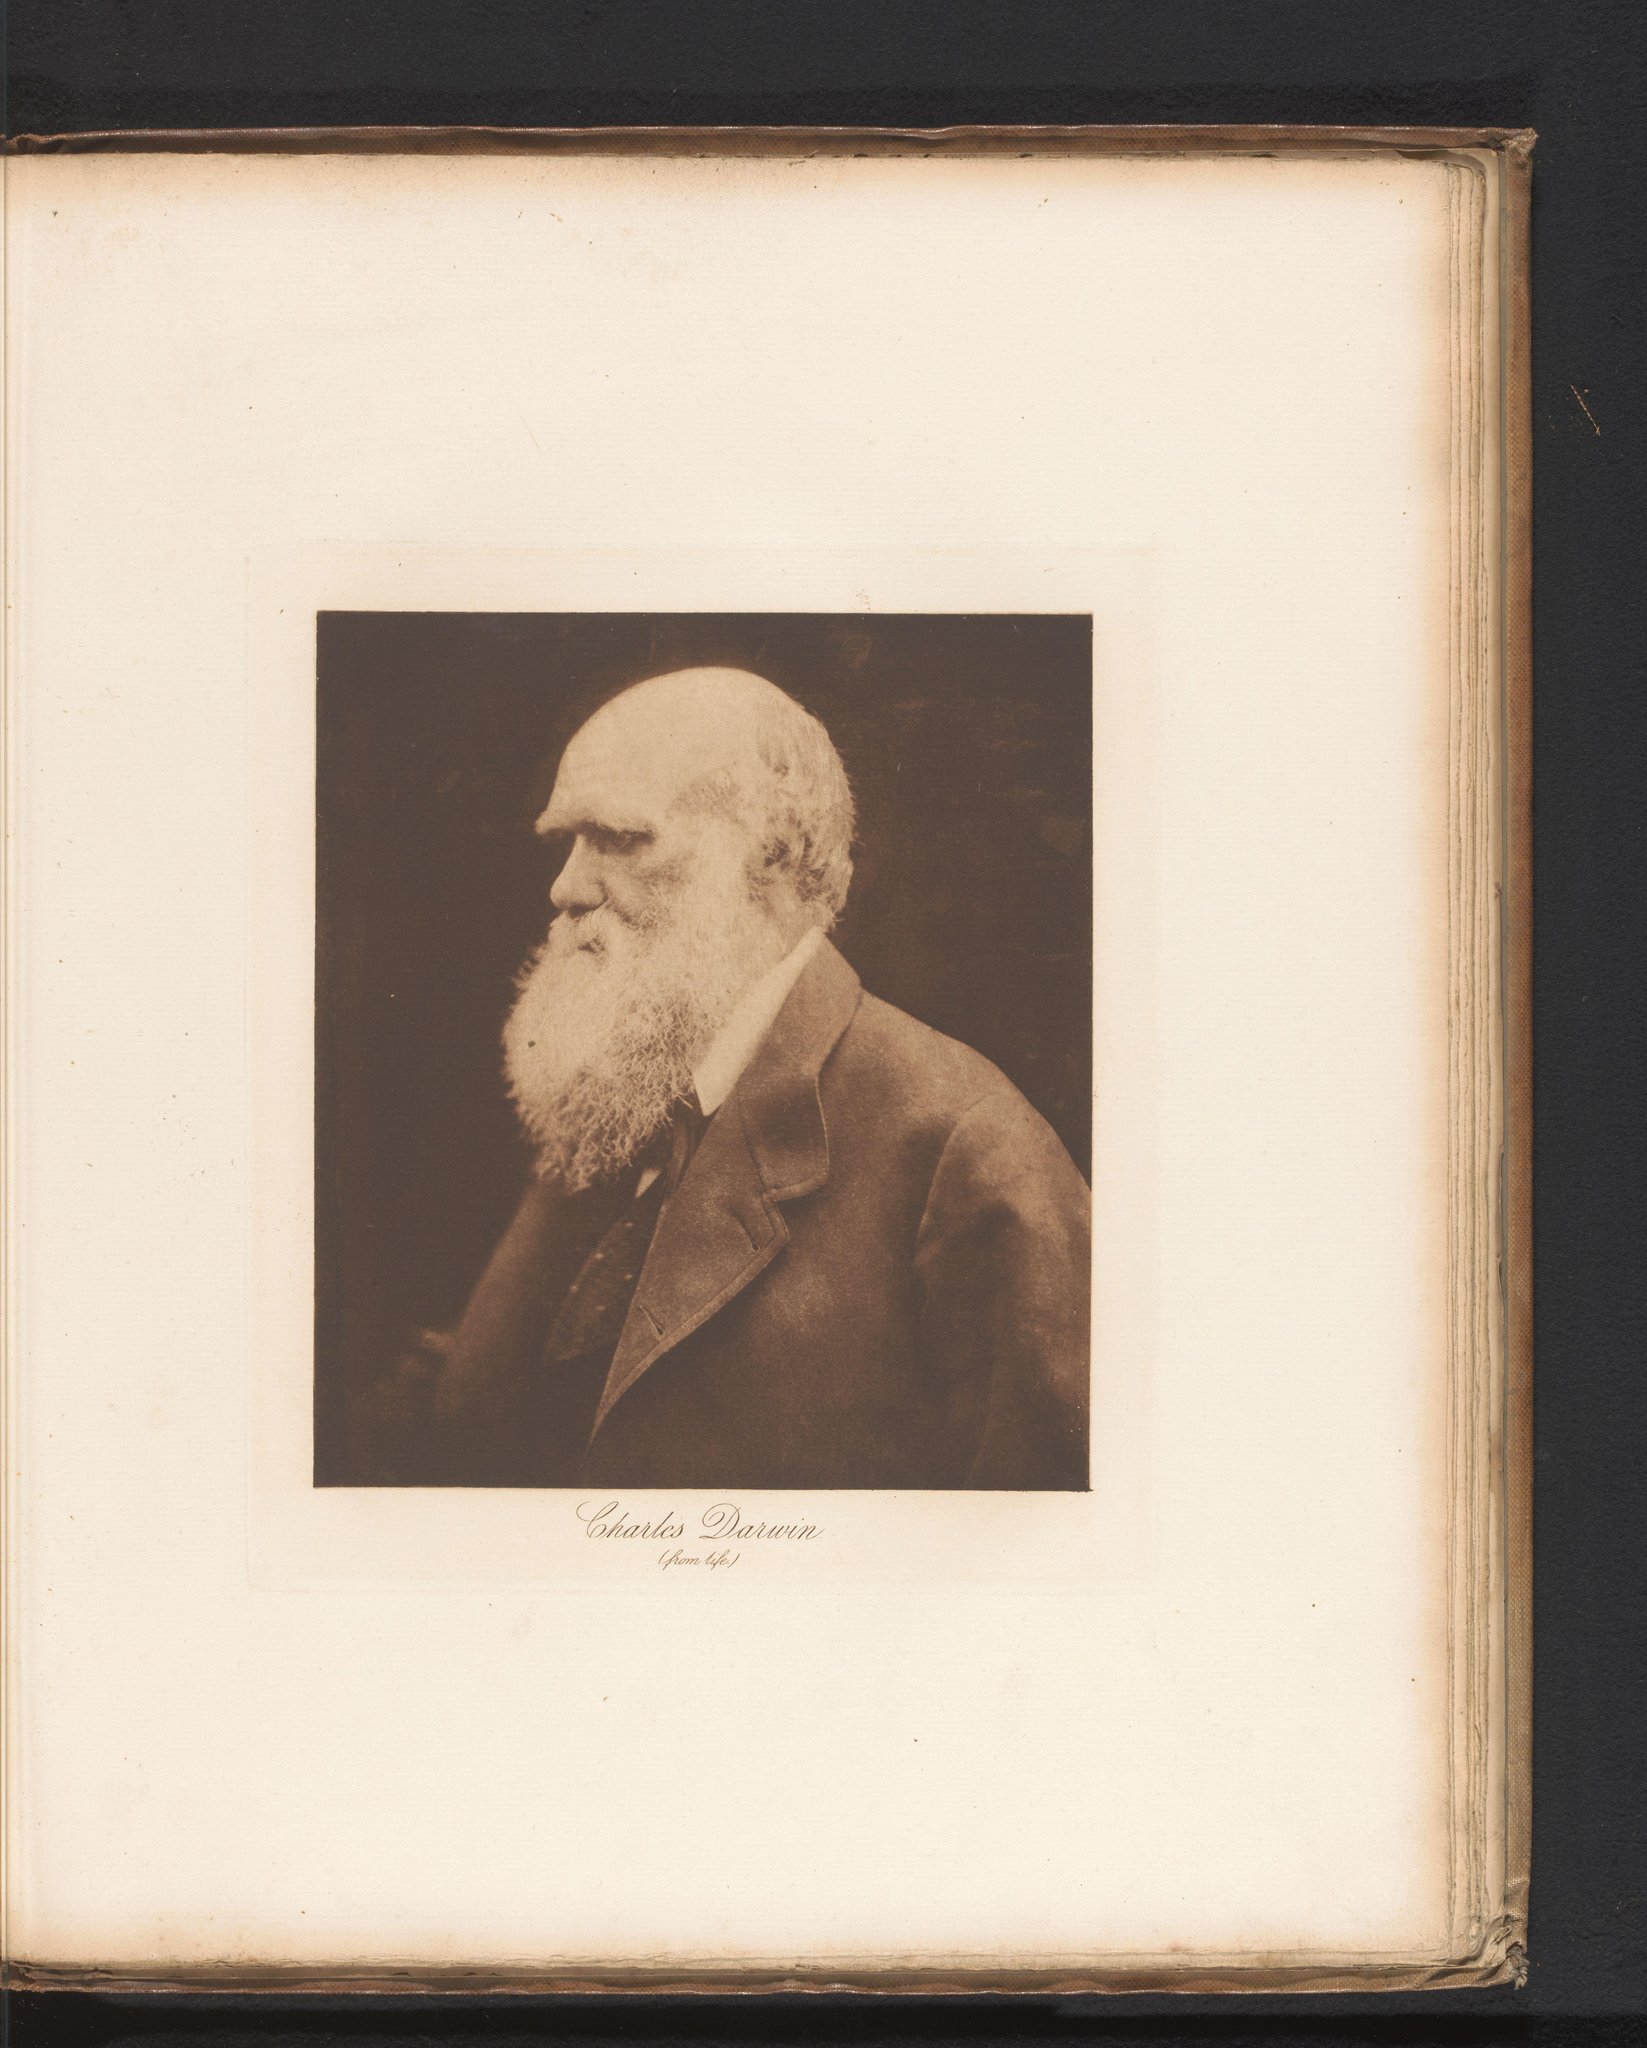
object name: page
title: Charles Darwin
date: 1868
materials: paper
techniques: photoaquatint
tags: charles darwin, historical persons, biology (+ portrait of scholar, scientist)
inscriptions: inscription: ‘Charles Darwin./ (from life.)’